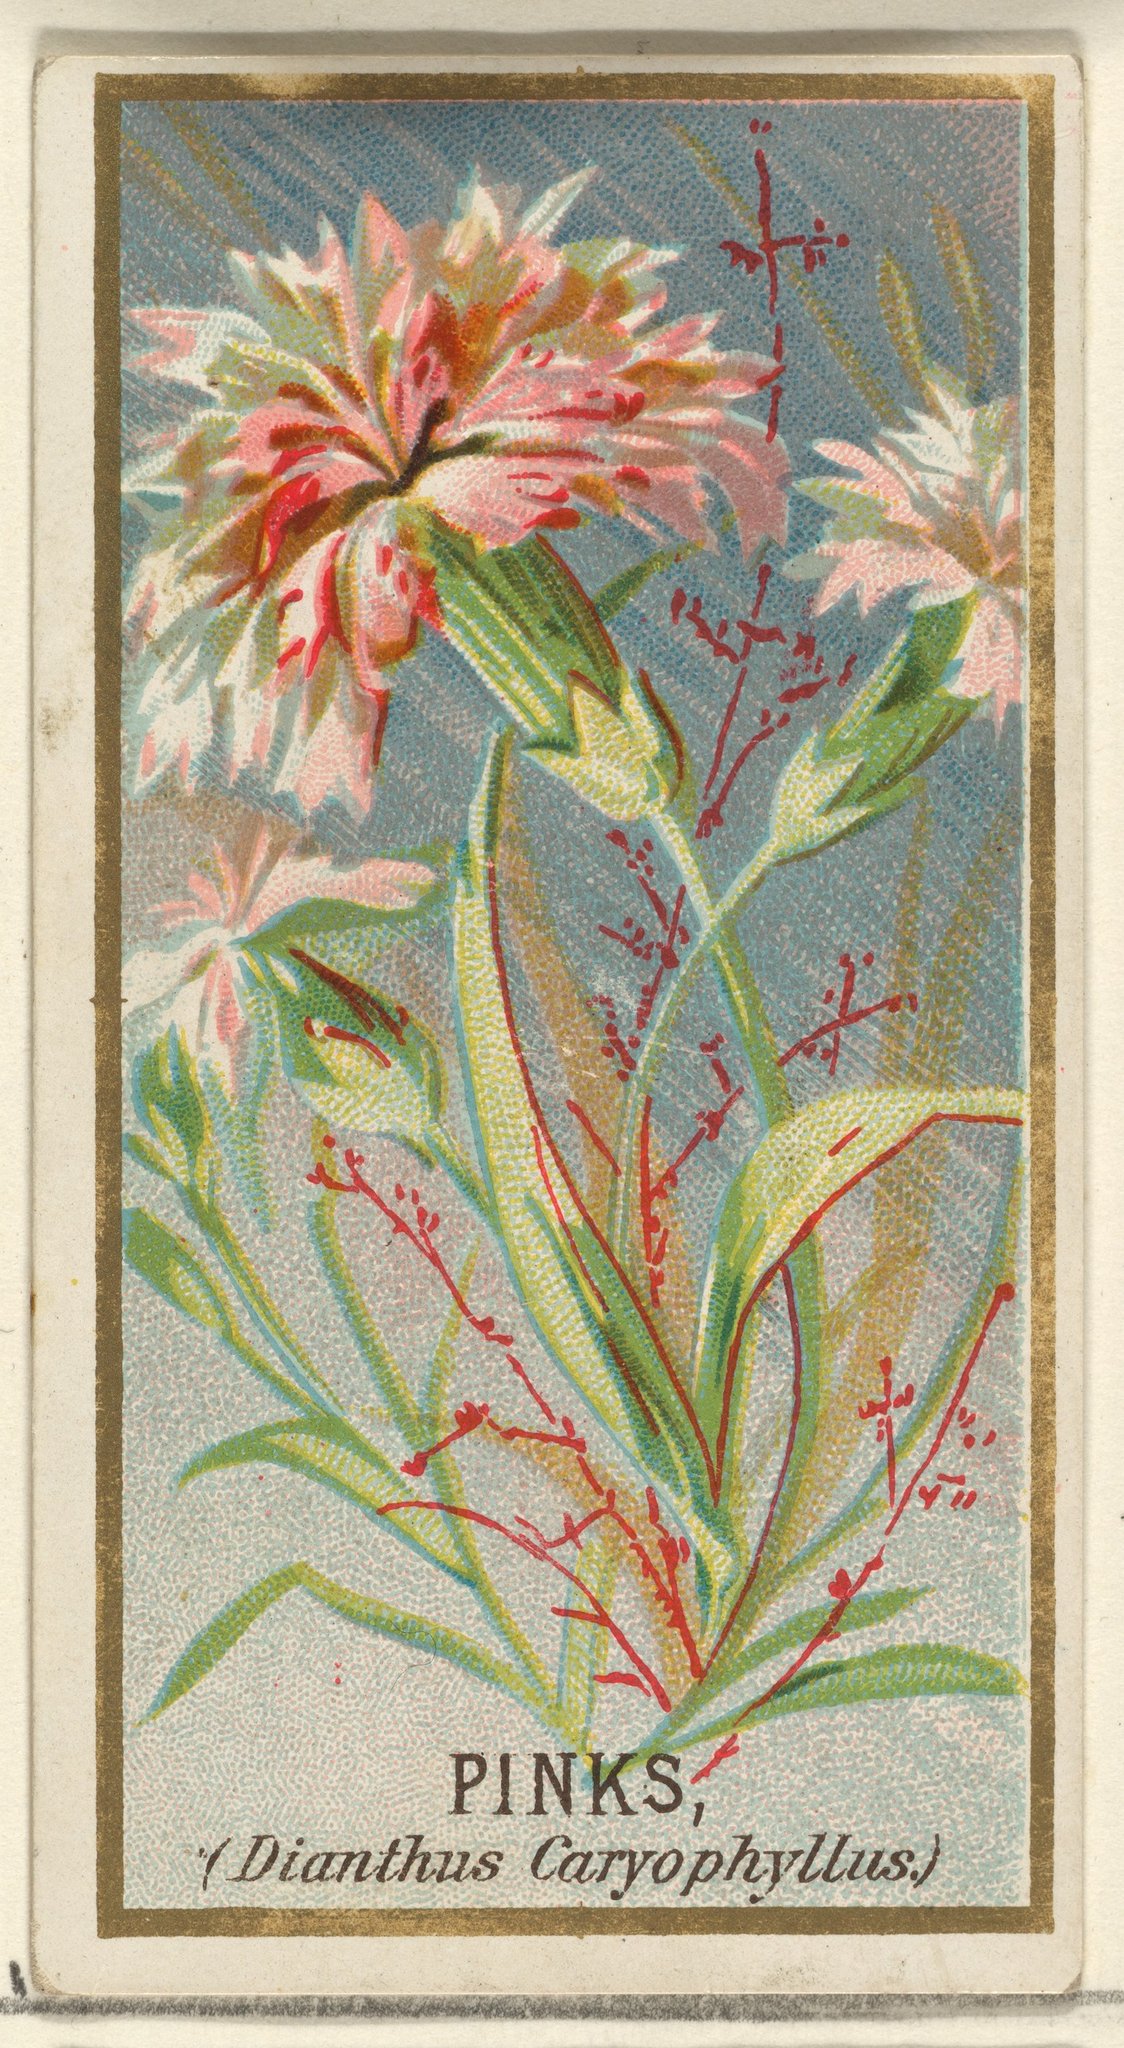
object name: print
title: Pinks (Dianthus Caryophyllus), from the Flowers series for Old Judge Cigarettes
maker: goodwin & company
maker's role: publisher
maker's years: 1850-1950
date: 1890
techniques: color lithograph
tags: flowers,leaves